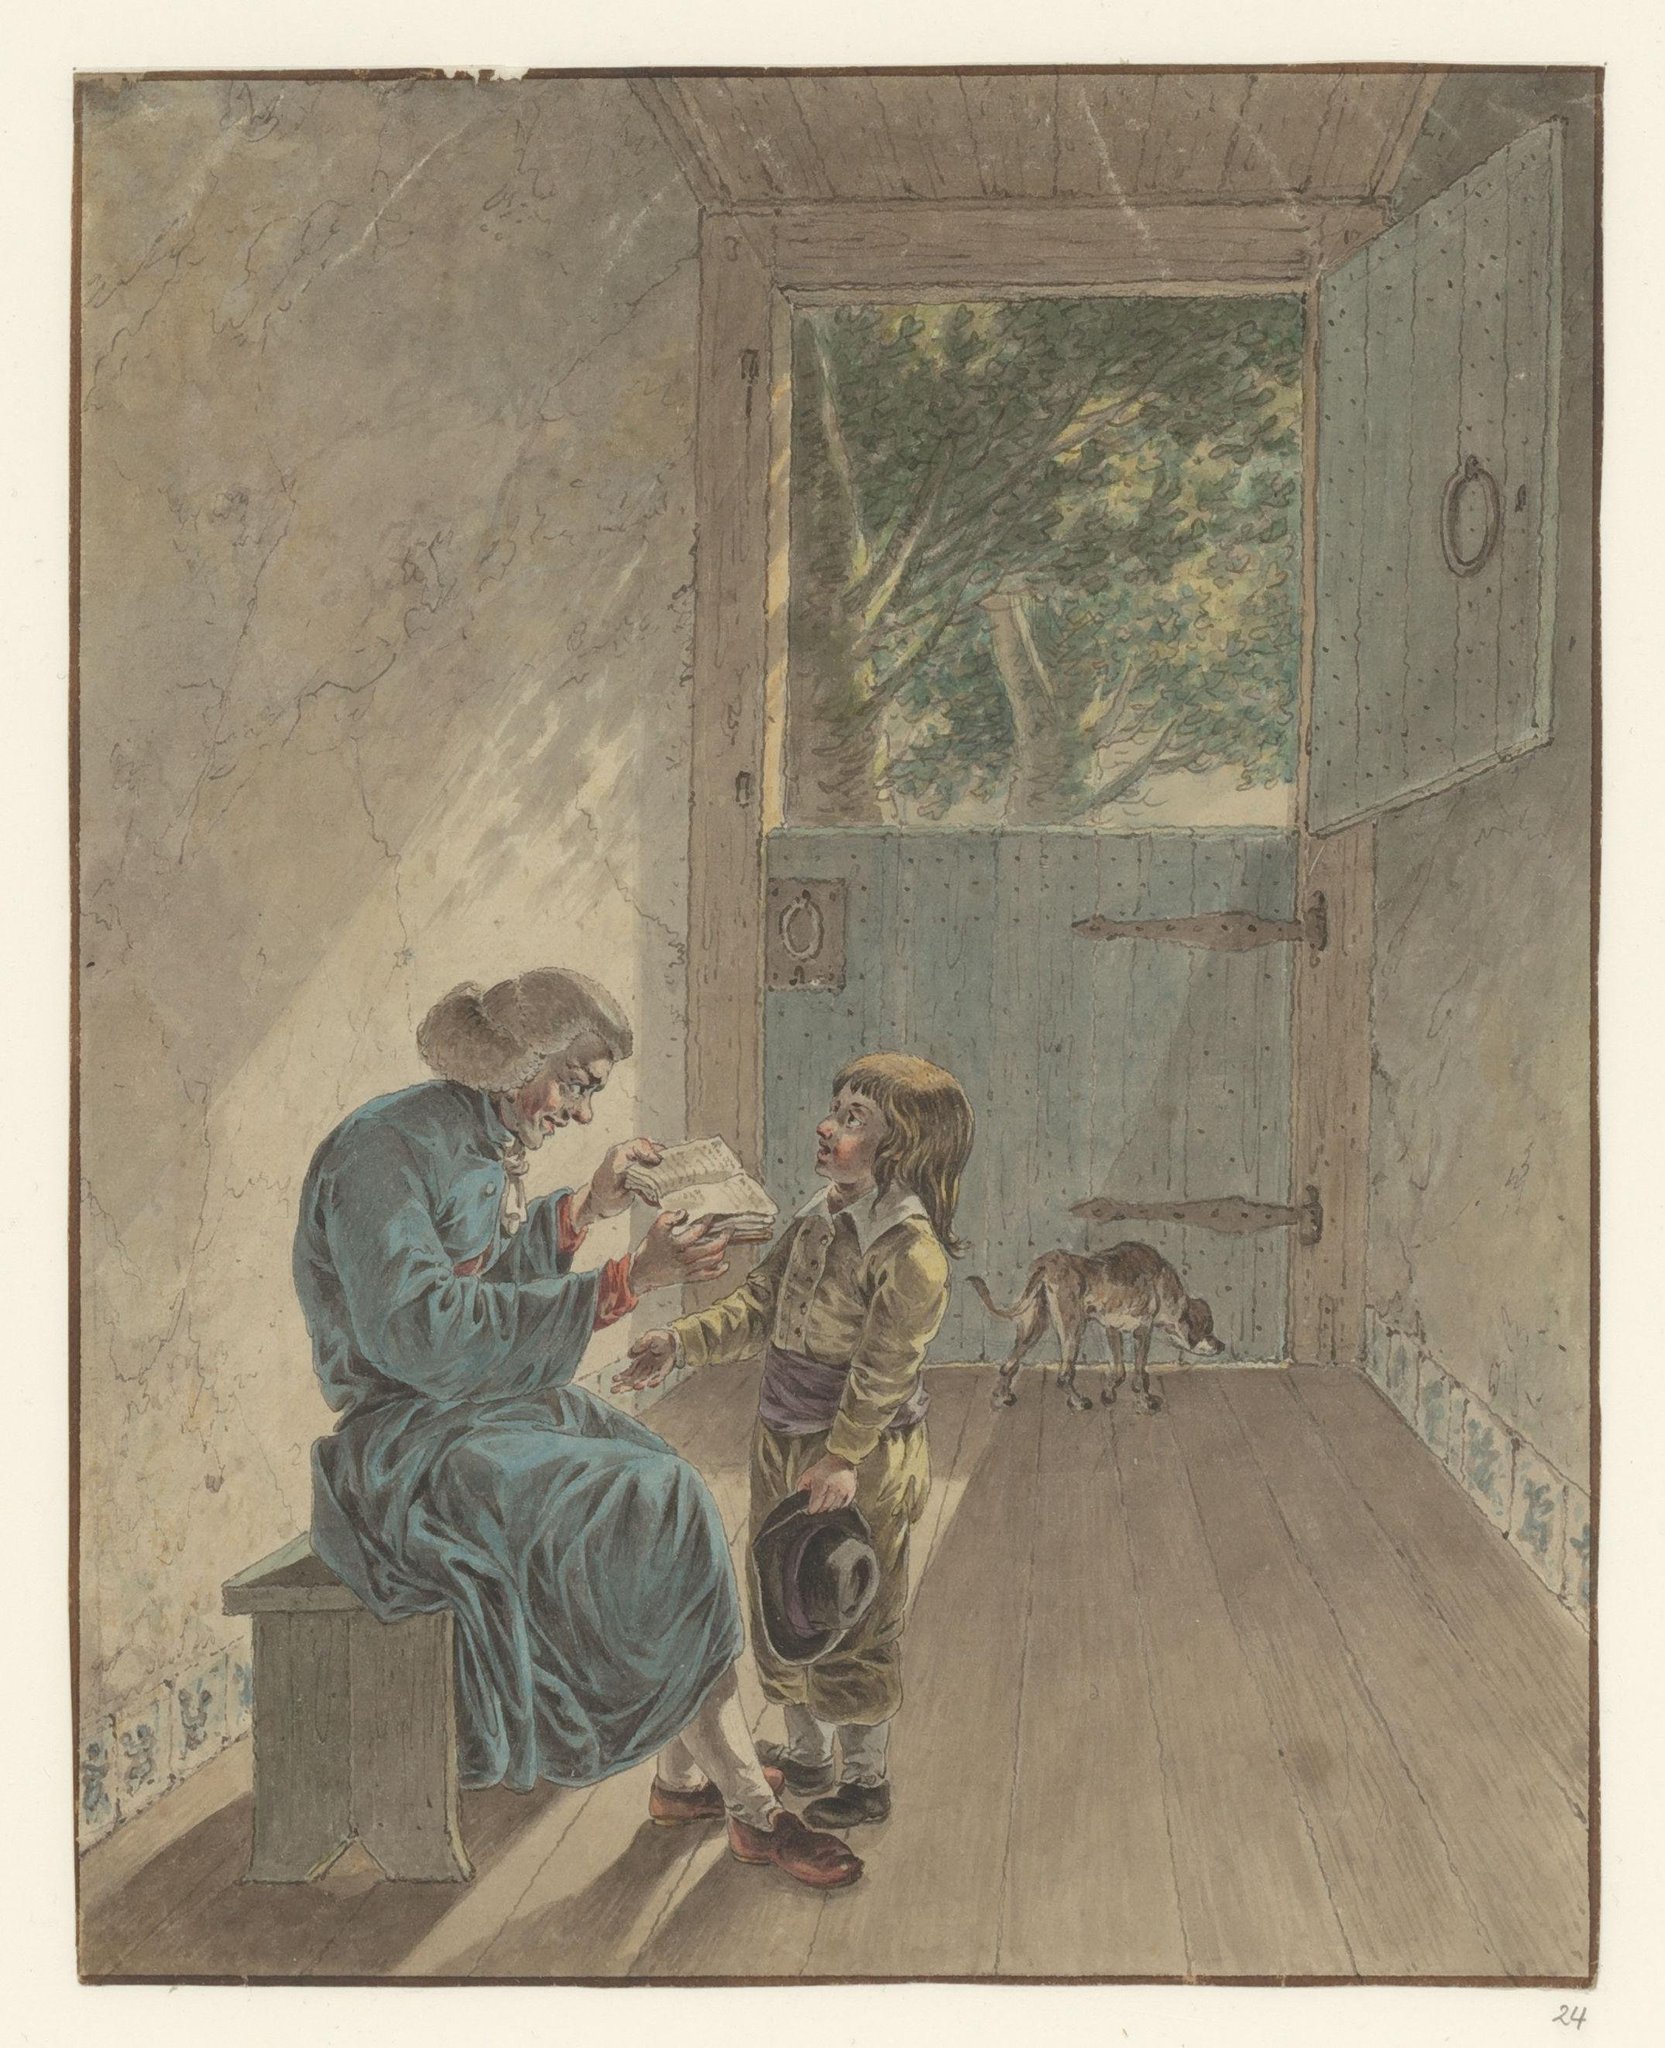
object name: drawing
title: Leraar overhoort een kind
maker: Anonymous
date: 1819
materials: ink, paper, watercolor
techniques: brush, pen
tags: teacher and pupil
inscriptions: stamp, collector's mark: Lugt 1641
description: Leraar in een kamerjapon overhoort een jongen op de gang. Onderwerpsrubrieken binnen de Atlas Zeden en Gewoonten: Onderwijs en Wetenschappen, Opvoeding en Onderwijs, Schoolmeesters.